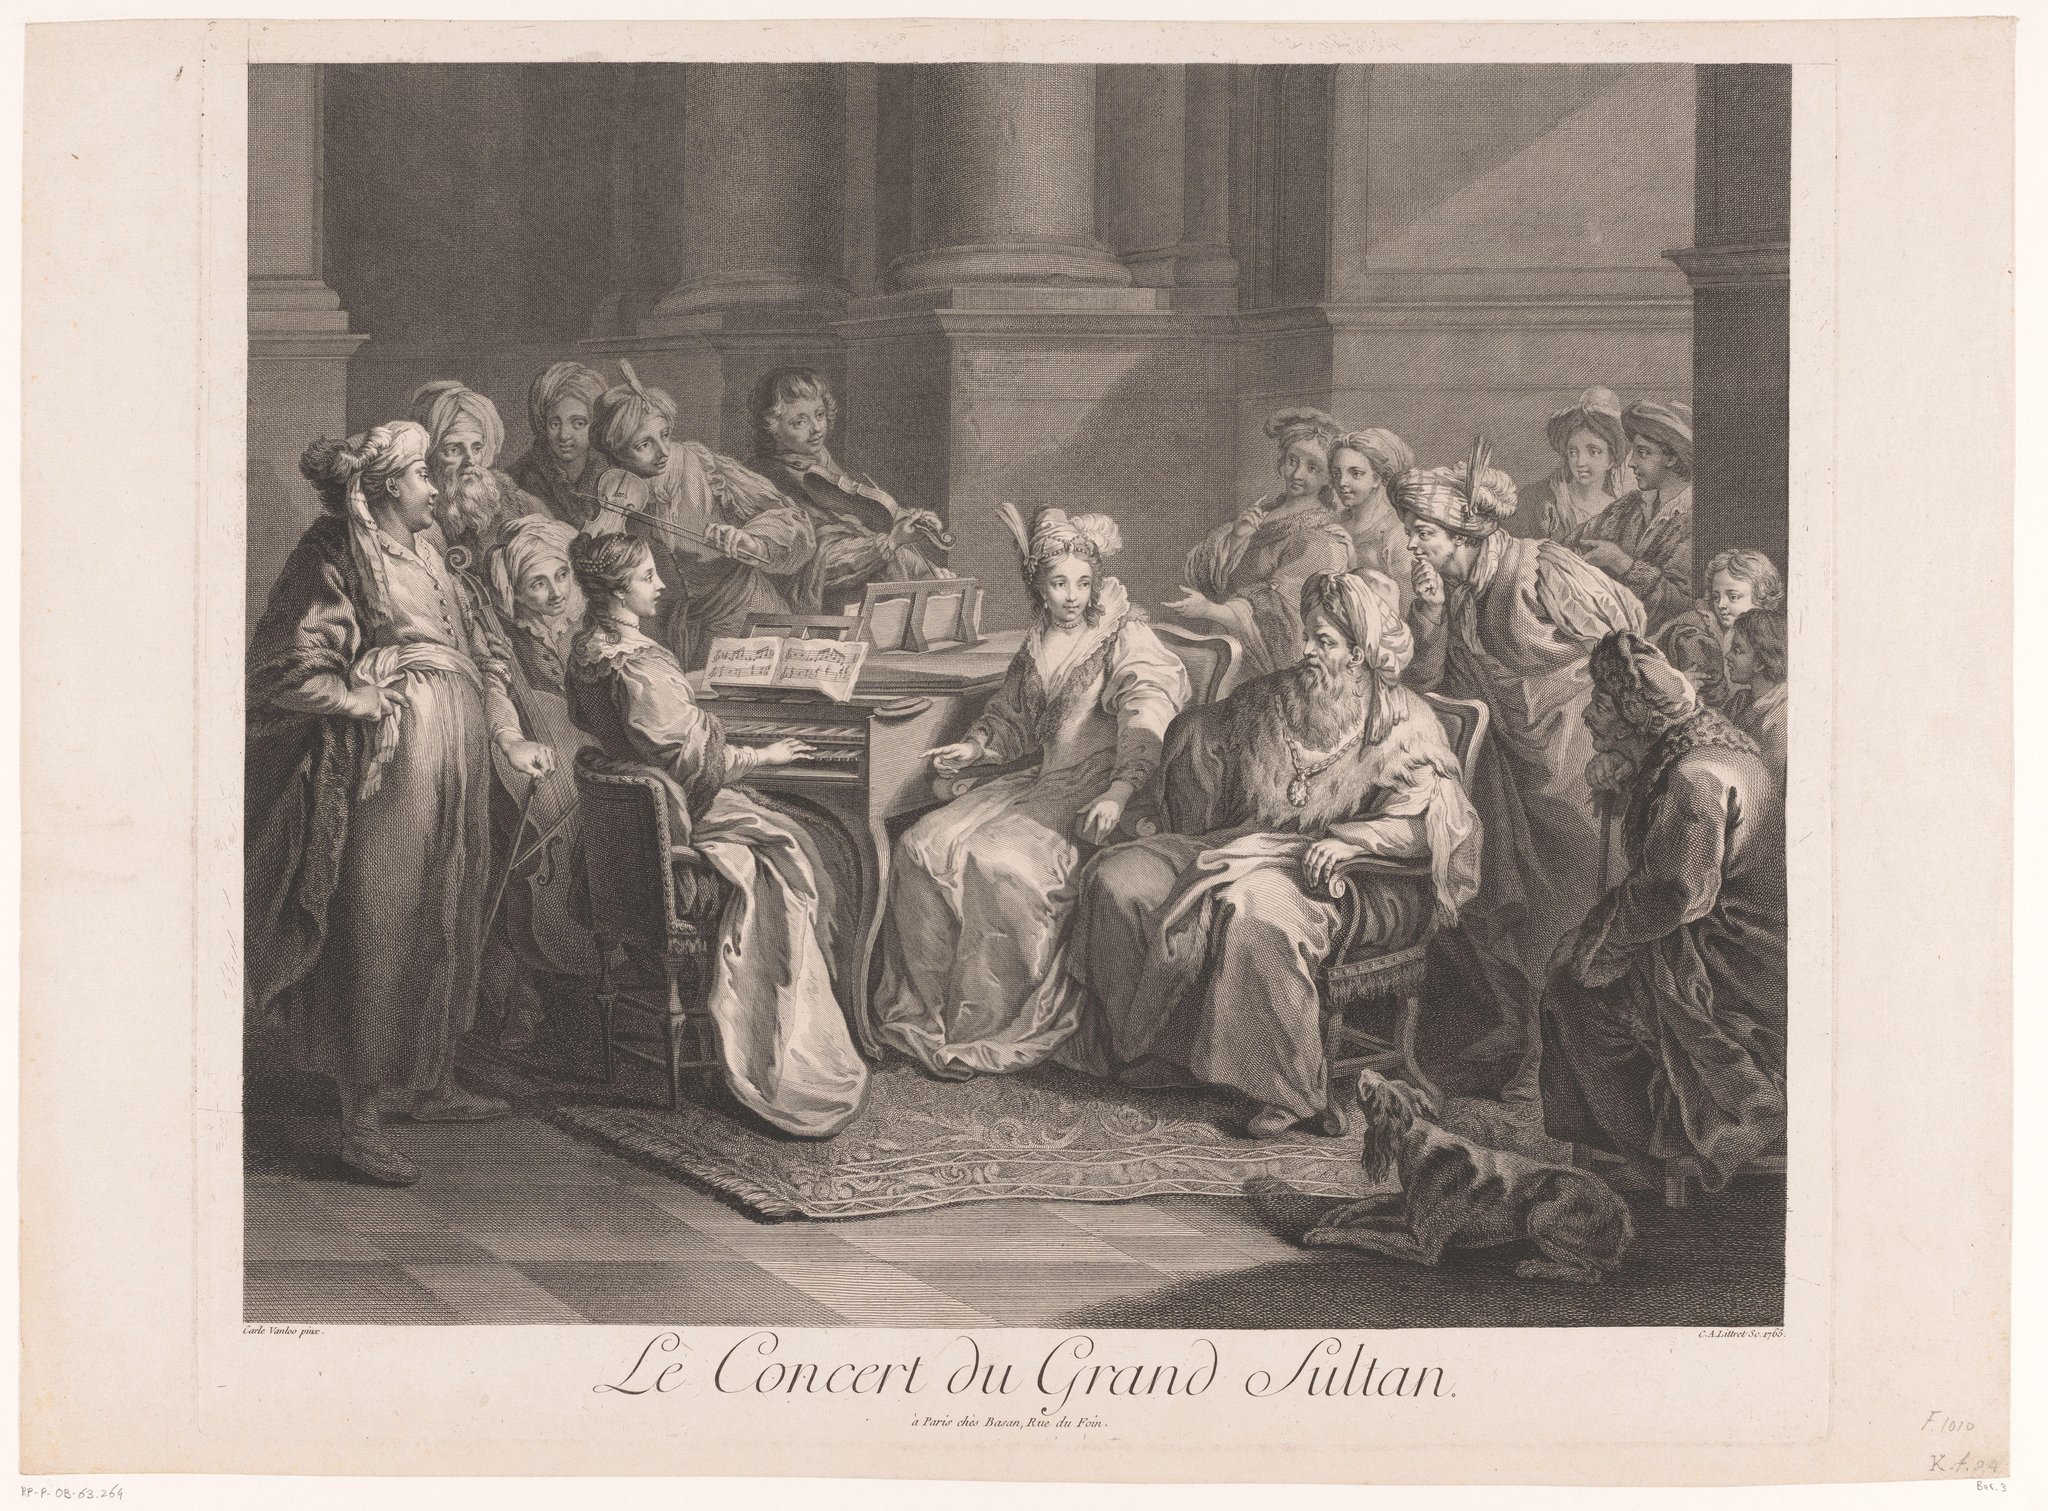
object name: print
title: Concert voor de sultan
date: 1765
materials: paper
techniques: engraving, etching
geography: paris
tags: listening to music, head-gear: turban, more than one musician with instrument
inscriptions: inscription: ‘SB (monogram) (?)/ f 660,,10,-’, collector's mark: Lugt 240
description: Dame achter klavecimbel, zingend en spelend uit een muziekboek voor haar. Links een cellist en twee violisten. Rechts zit de sultan in een leunstoel, omringd door overige figuren, te luisteren. Naast de sultan zit een elegant geklede dame.